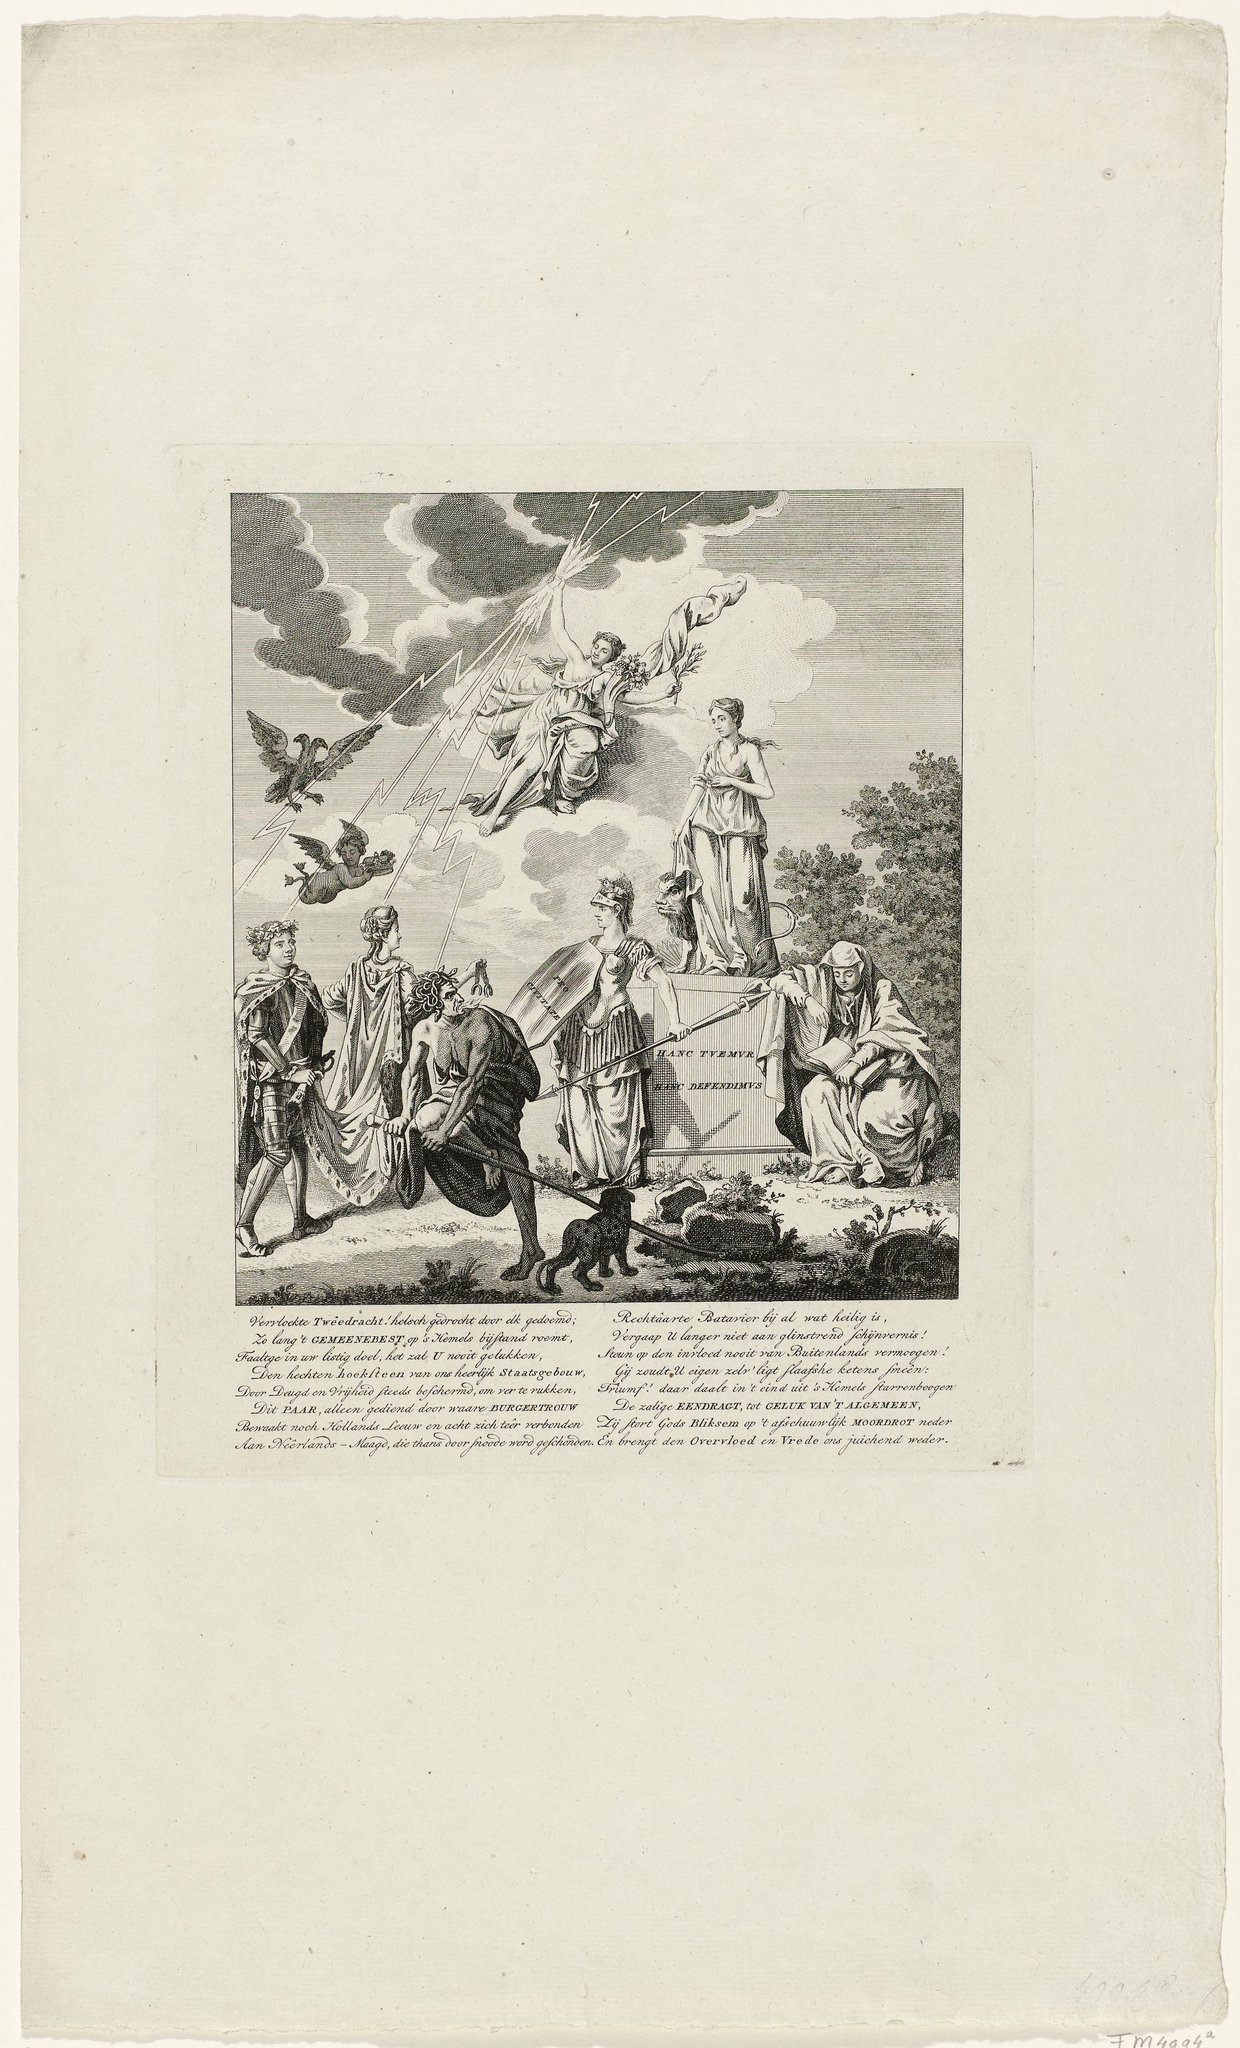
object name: print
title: Allegorie op de pogingen van Willem V om het land in slavernij te brengen, 1787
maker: Anonymous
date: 1787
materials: paper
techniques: engraving, etching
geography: northern netherlands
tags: william v (prince of orange), personifications of countries, nations, states, districts, etc., 'servitù', 'servitù per forza' (ripa), disagreement, discord; 'discordia' (ripa) (+ abstract concept represented by female figure), agreement, unity; 'concordia', 'concordia insuperabile', 'concordia militare', 'concordia di pace', 'unione civile' (ripa) (+ abstract concept represented by female figure), netherlands, patriots (1780-1795)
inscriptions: collector's mark: Lugt 2228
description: Patriotse allegorie op de pogingen van stadhouder Willem V om zijn macht te herstellen, 1787. De Nederlandse Maagd en Leeuw staande op de hoeksteen van het Staatsgebouw die Tweedracht tevergeefs tracht omver te werpen. Vrijheid beschermt het staatsgebouw tegen Willem V en Slavernij. De Eendracht laat vanuit de hemel bliksemschichten neerdalen op de Tweedracht, Willem V en Slavernij. Met onderschrift in twee kolommen. Bij de prent behoort een afzonderlijke verklaring.